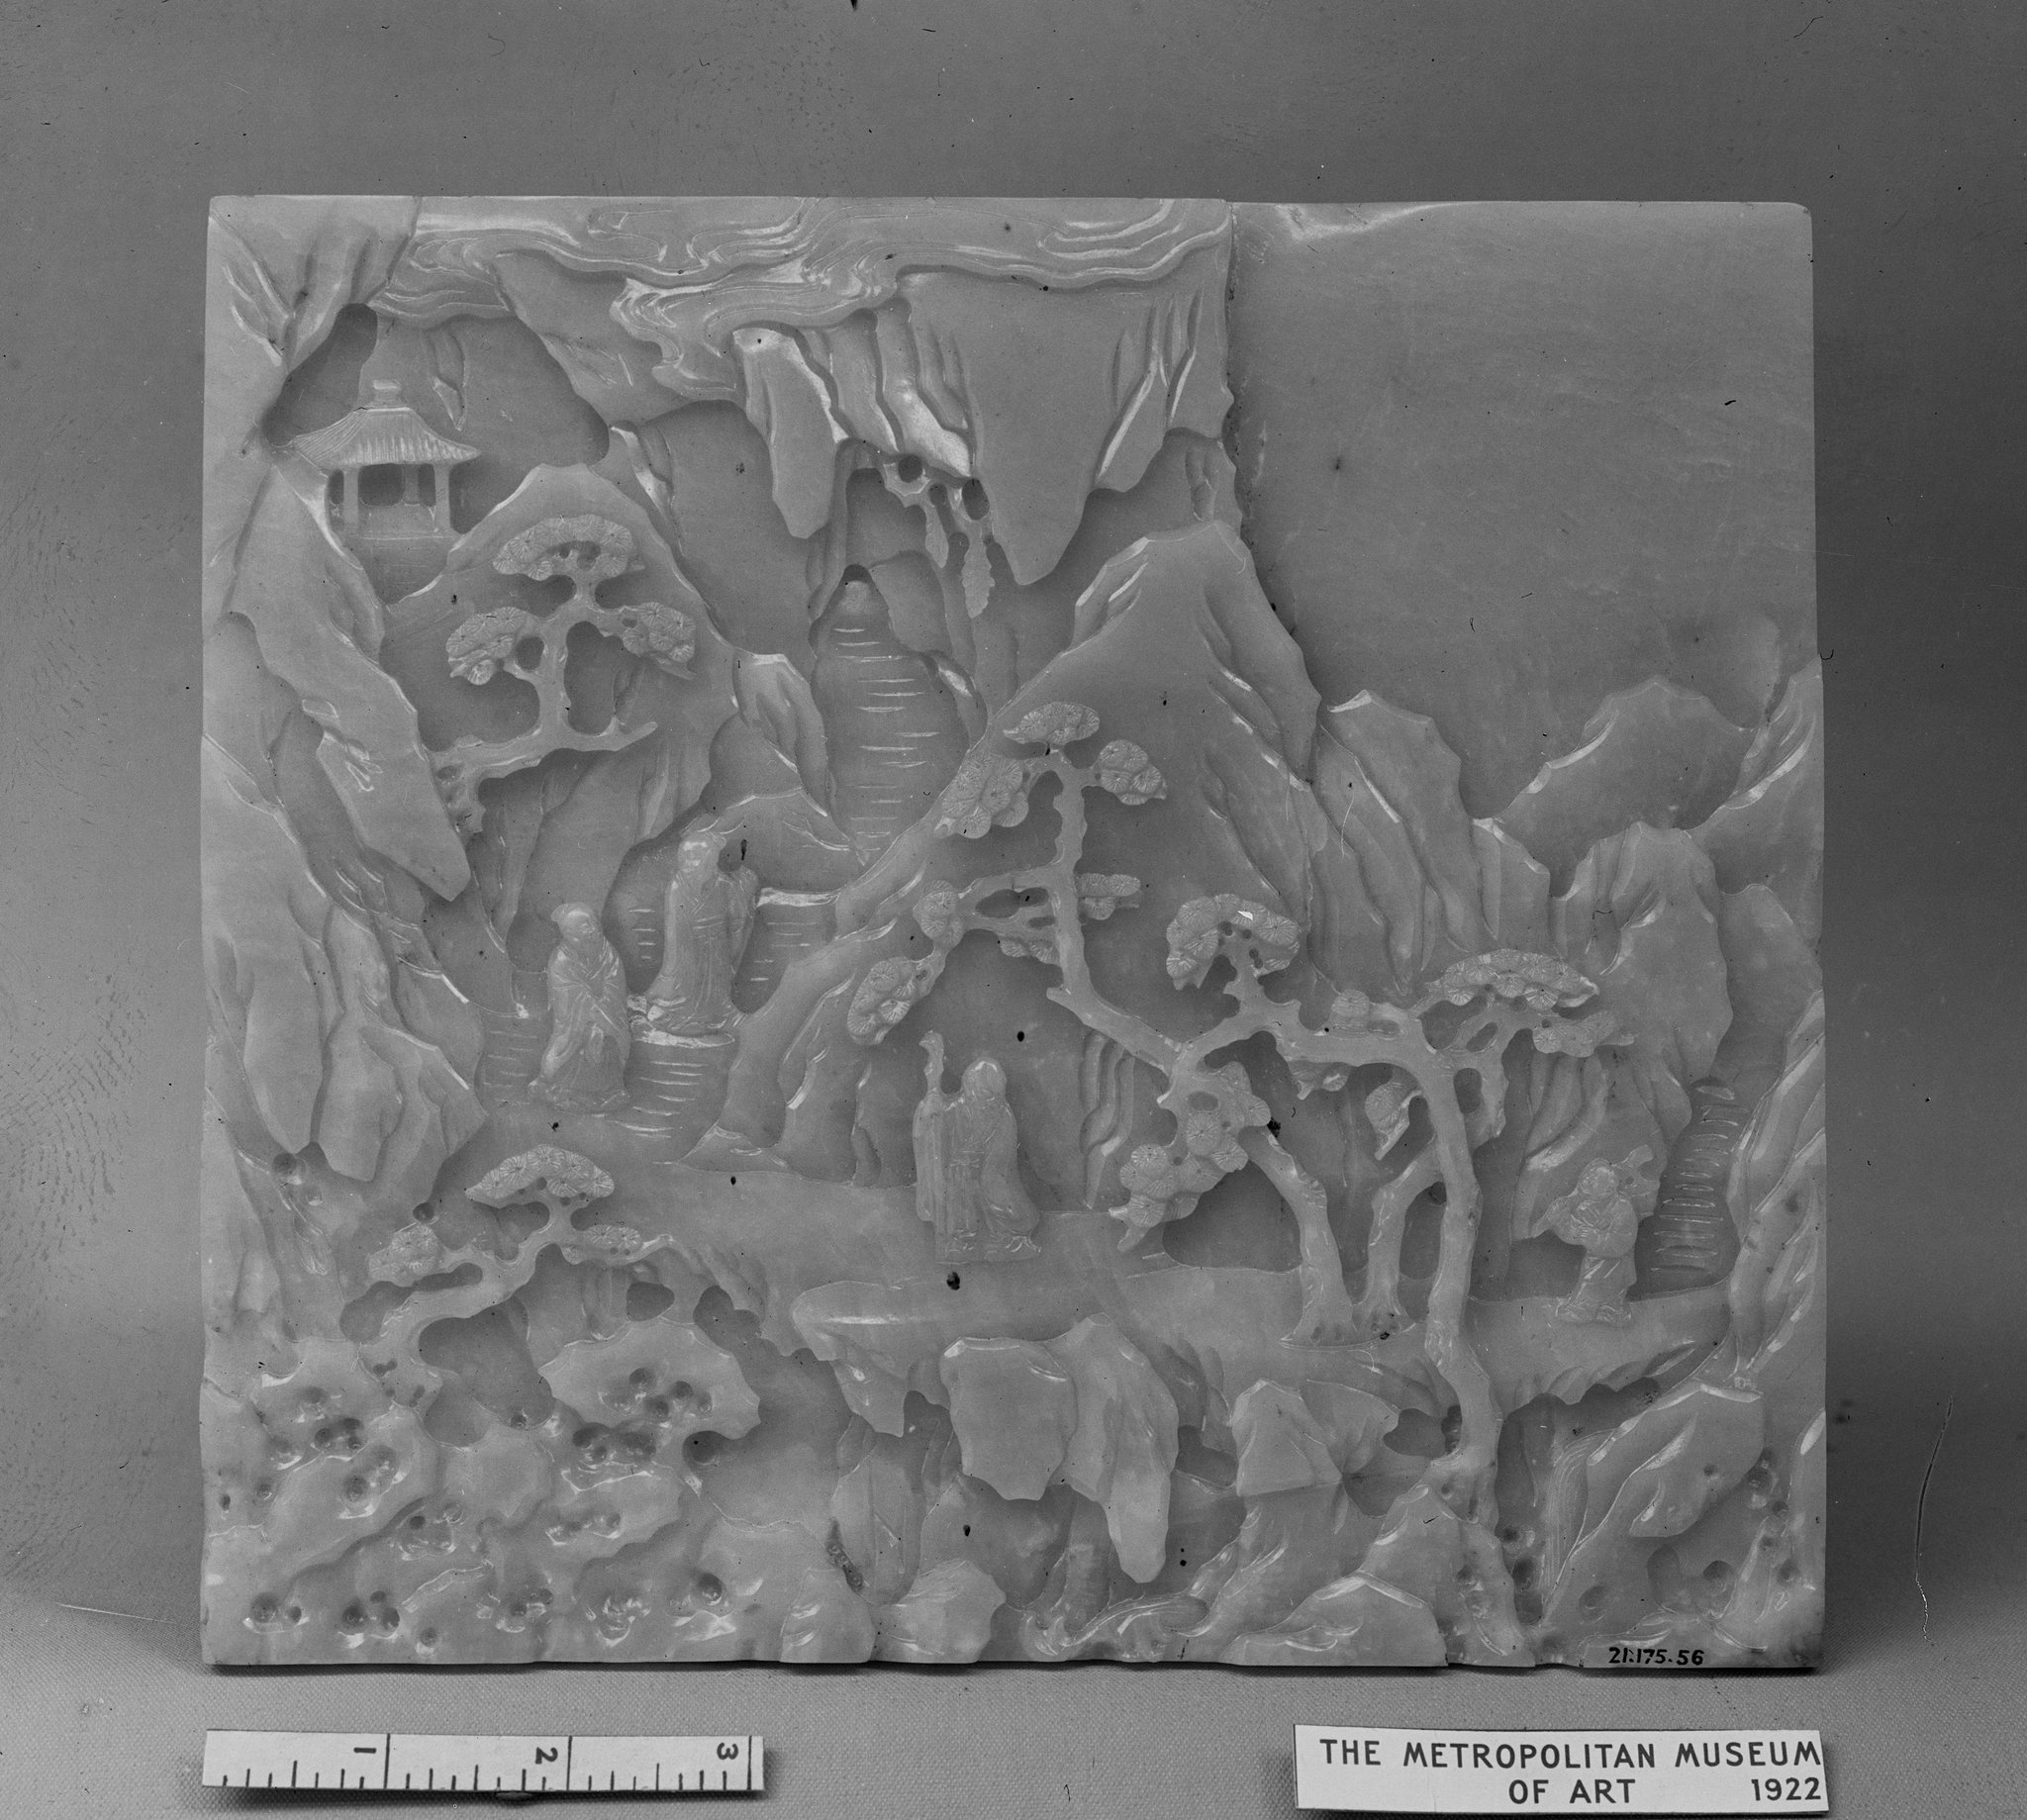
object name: table screen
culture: chinese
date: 1736-1795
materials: jade